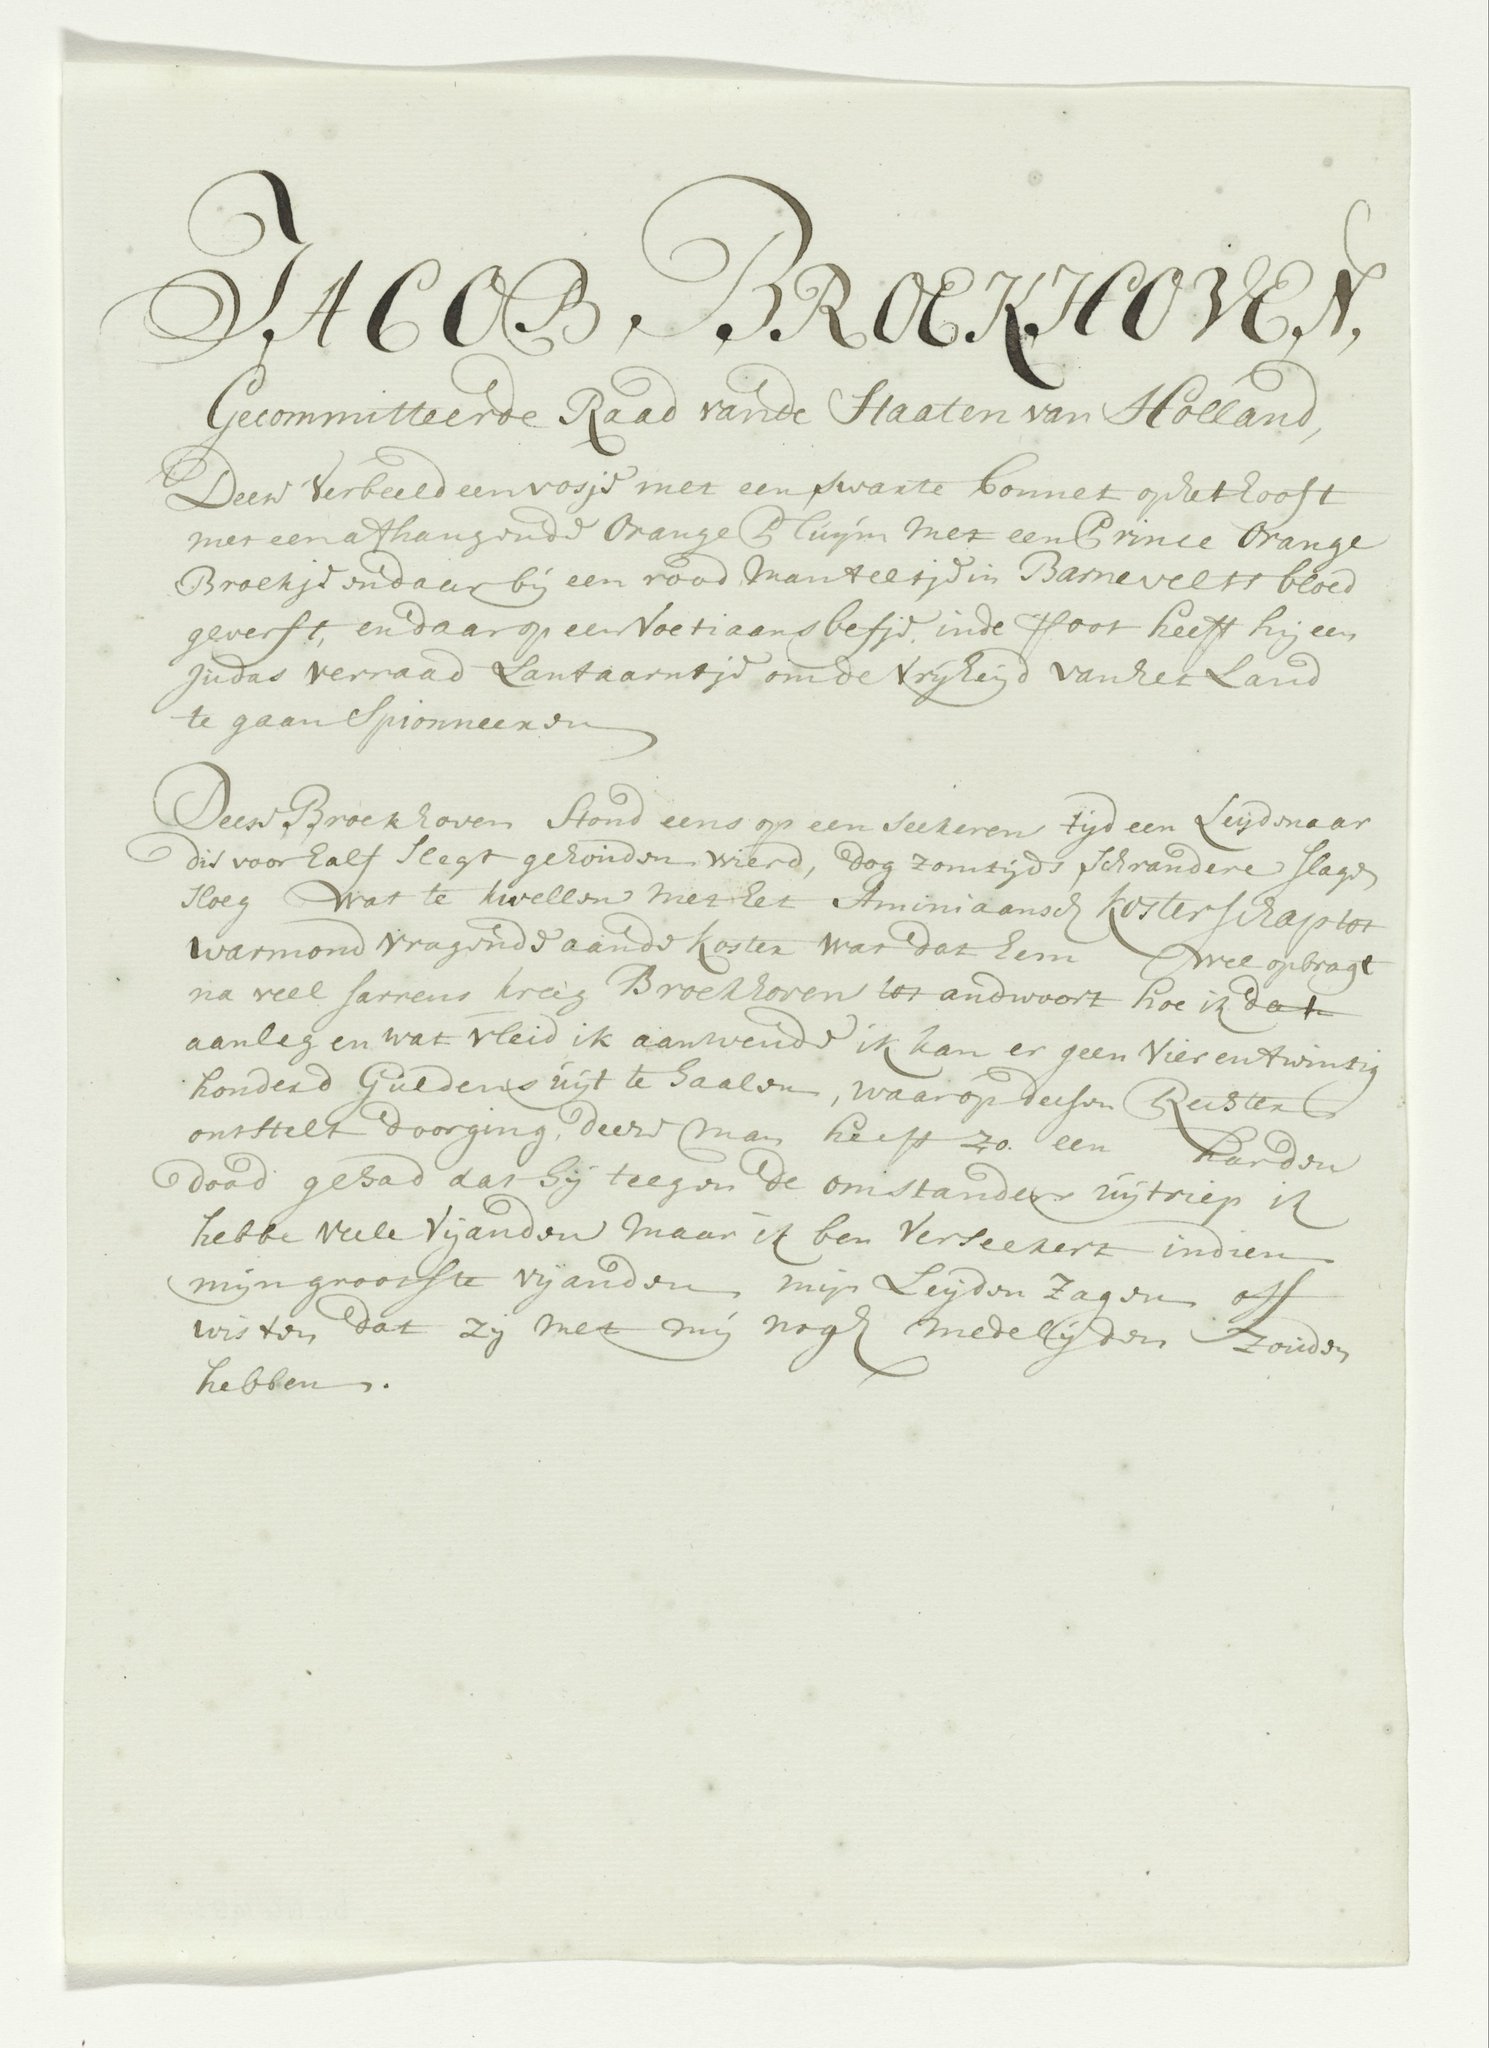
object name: manuscript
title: Spotvers bij het portret van Jacob Broekhoven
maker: Anonymous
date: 1710-1720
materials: paper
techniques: pen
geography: netherlands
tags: the hague, johan van oldenbarnevelt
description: Spotprent van Jacob Broekhoven, rechter van Van Oldenbarnevelt; vos met oranje kniebroek, manteltje waarop wapen en bonnet met oranje pluim, in krans van druivenranken. Daaronder cartouche met aan weerszijden twee trompetblazende putti. In cartouche naam en daarboven nr. 11. Behorende bij serie aquarellen in boek.